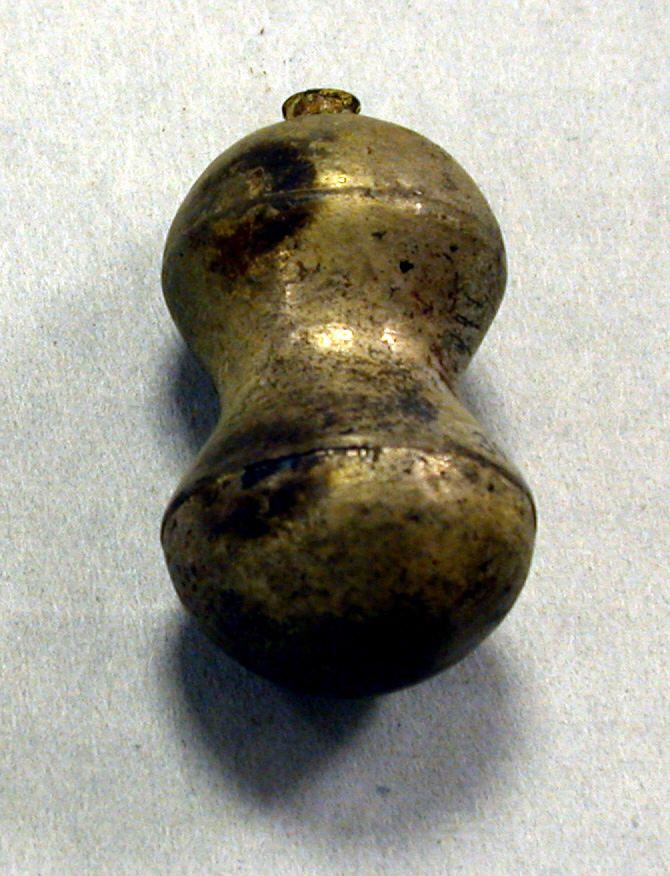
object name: ornament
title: Hammered Silver Peanut Ornament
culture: peruvian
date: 701-1566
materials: gilt, silver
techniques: hammering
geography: peru